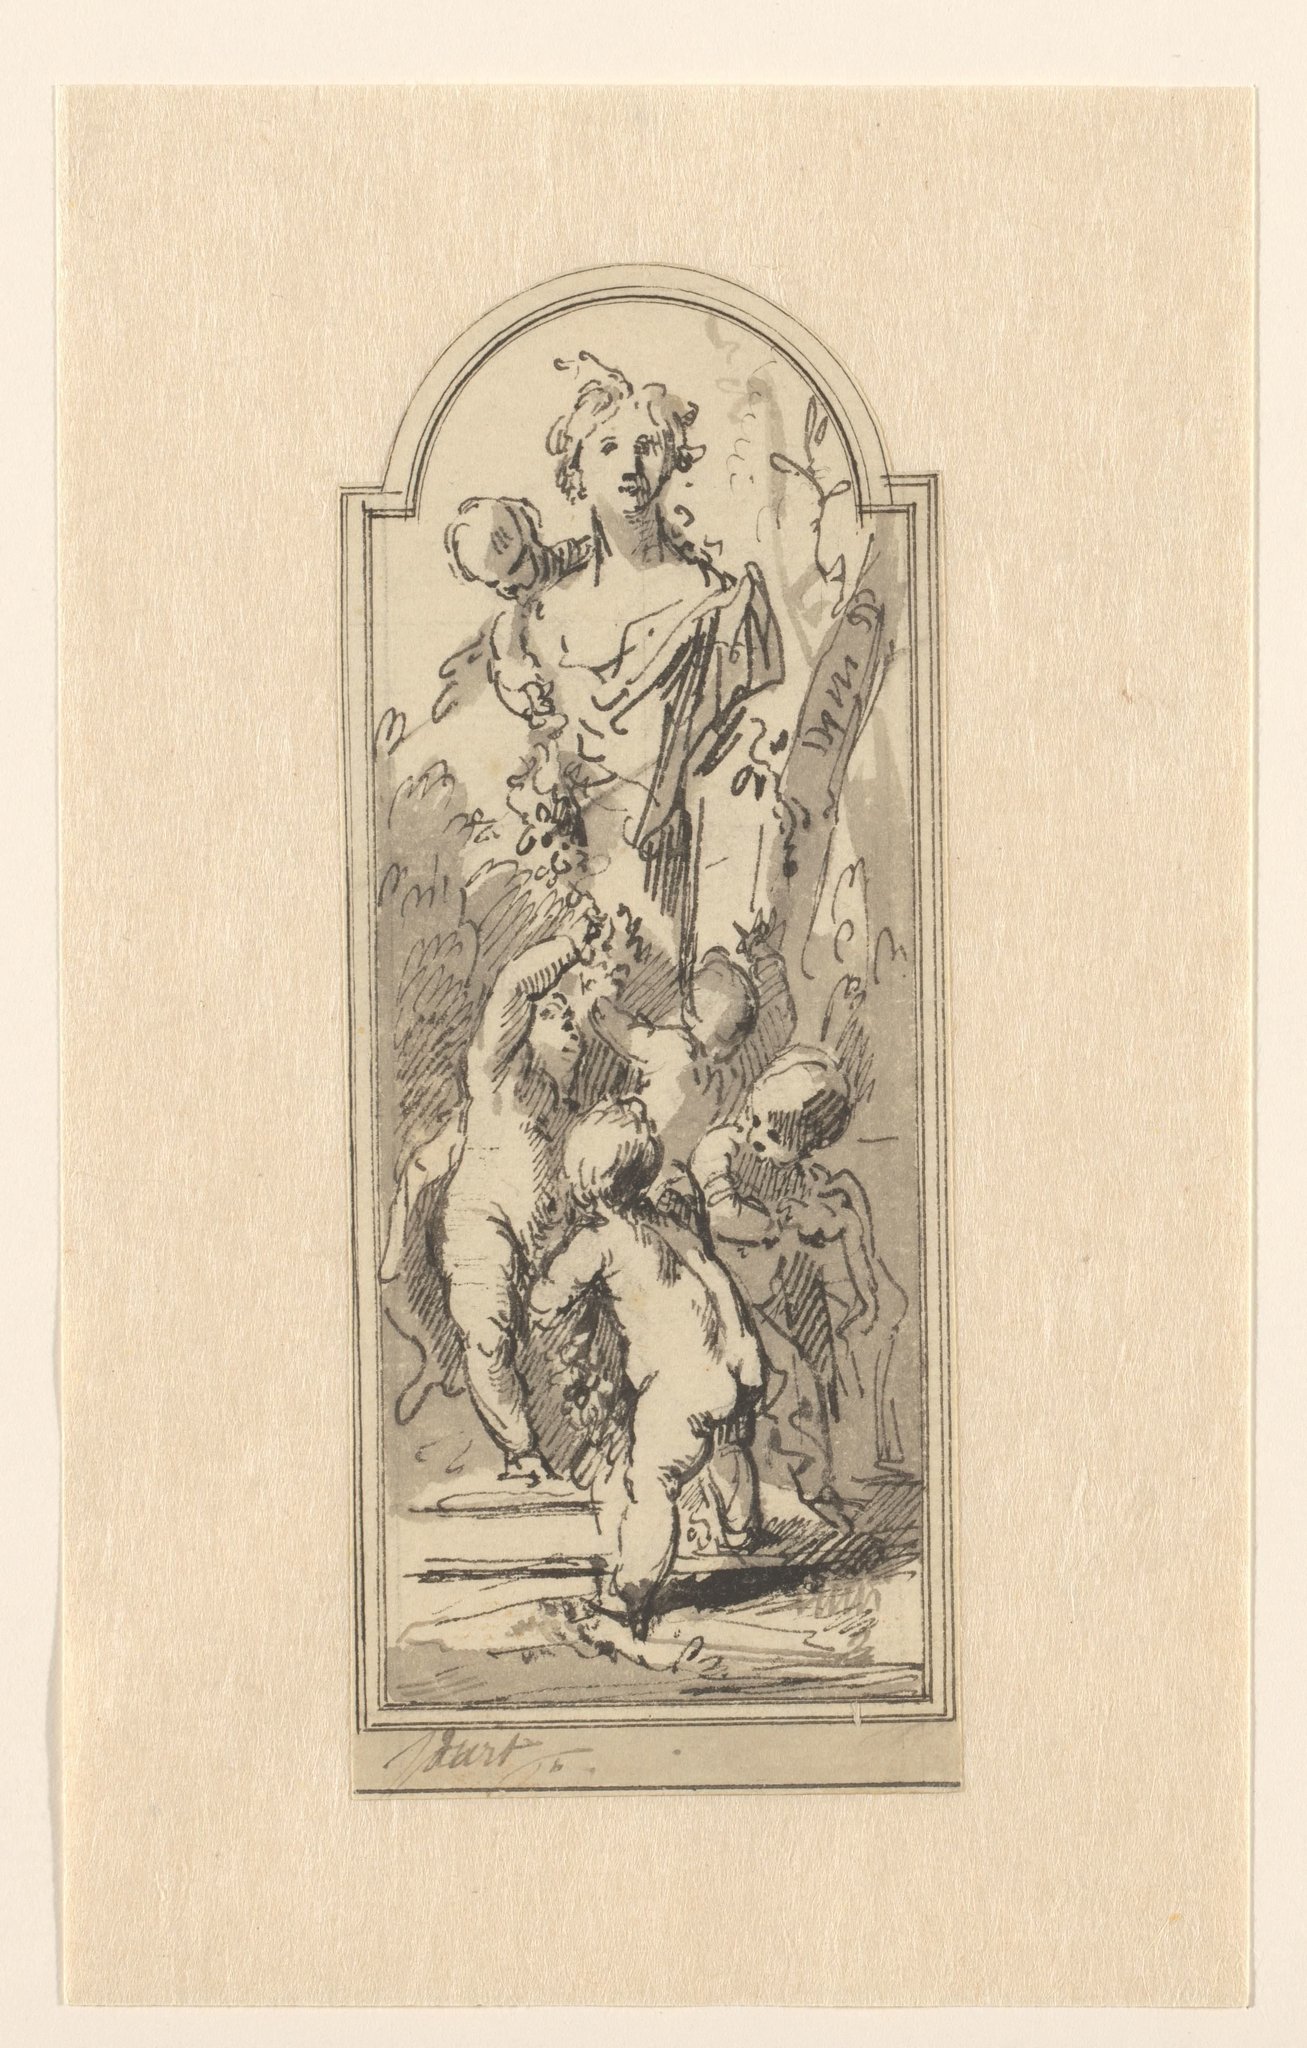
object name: drawing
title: Putti met buste van vrouw tussen bomen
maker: jacob de wit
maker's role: draughtsman, painter, print maker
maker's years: 1695-1754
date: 1705-1754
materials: ink, paper, pencil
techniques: brush, pen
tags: cupids: 'amores', 'amoretti', 'putti'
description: Op zelfde passepartout als RP-T-1898-A-3754.